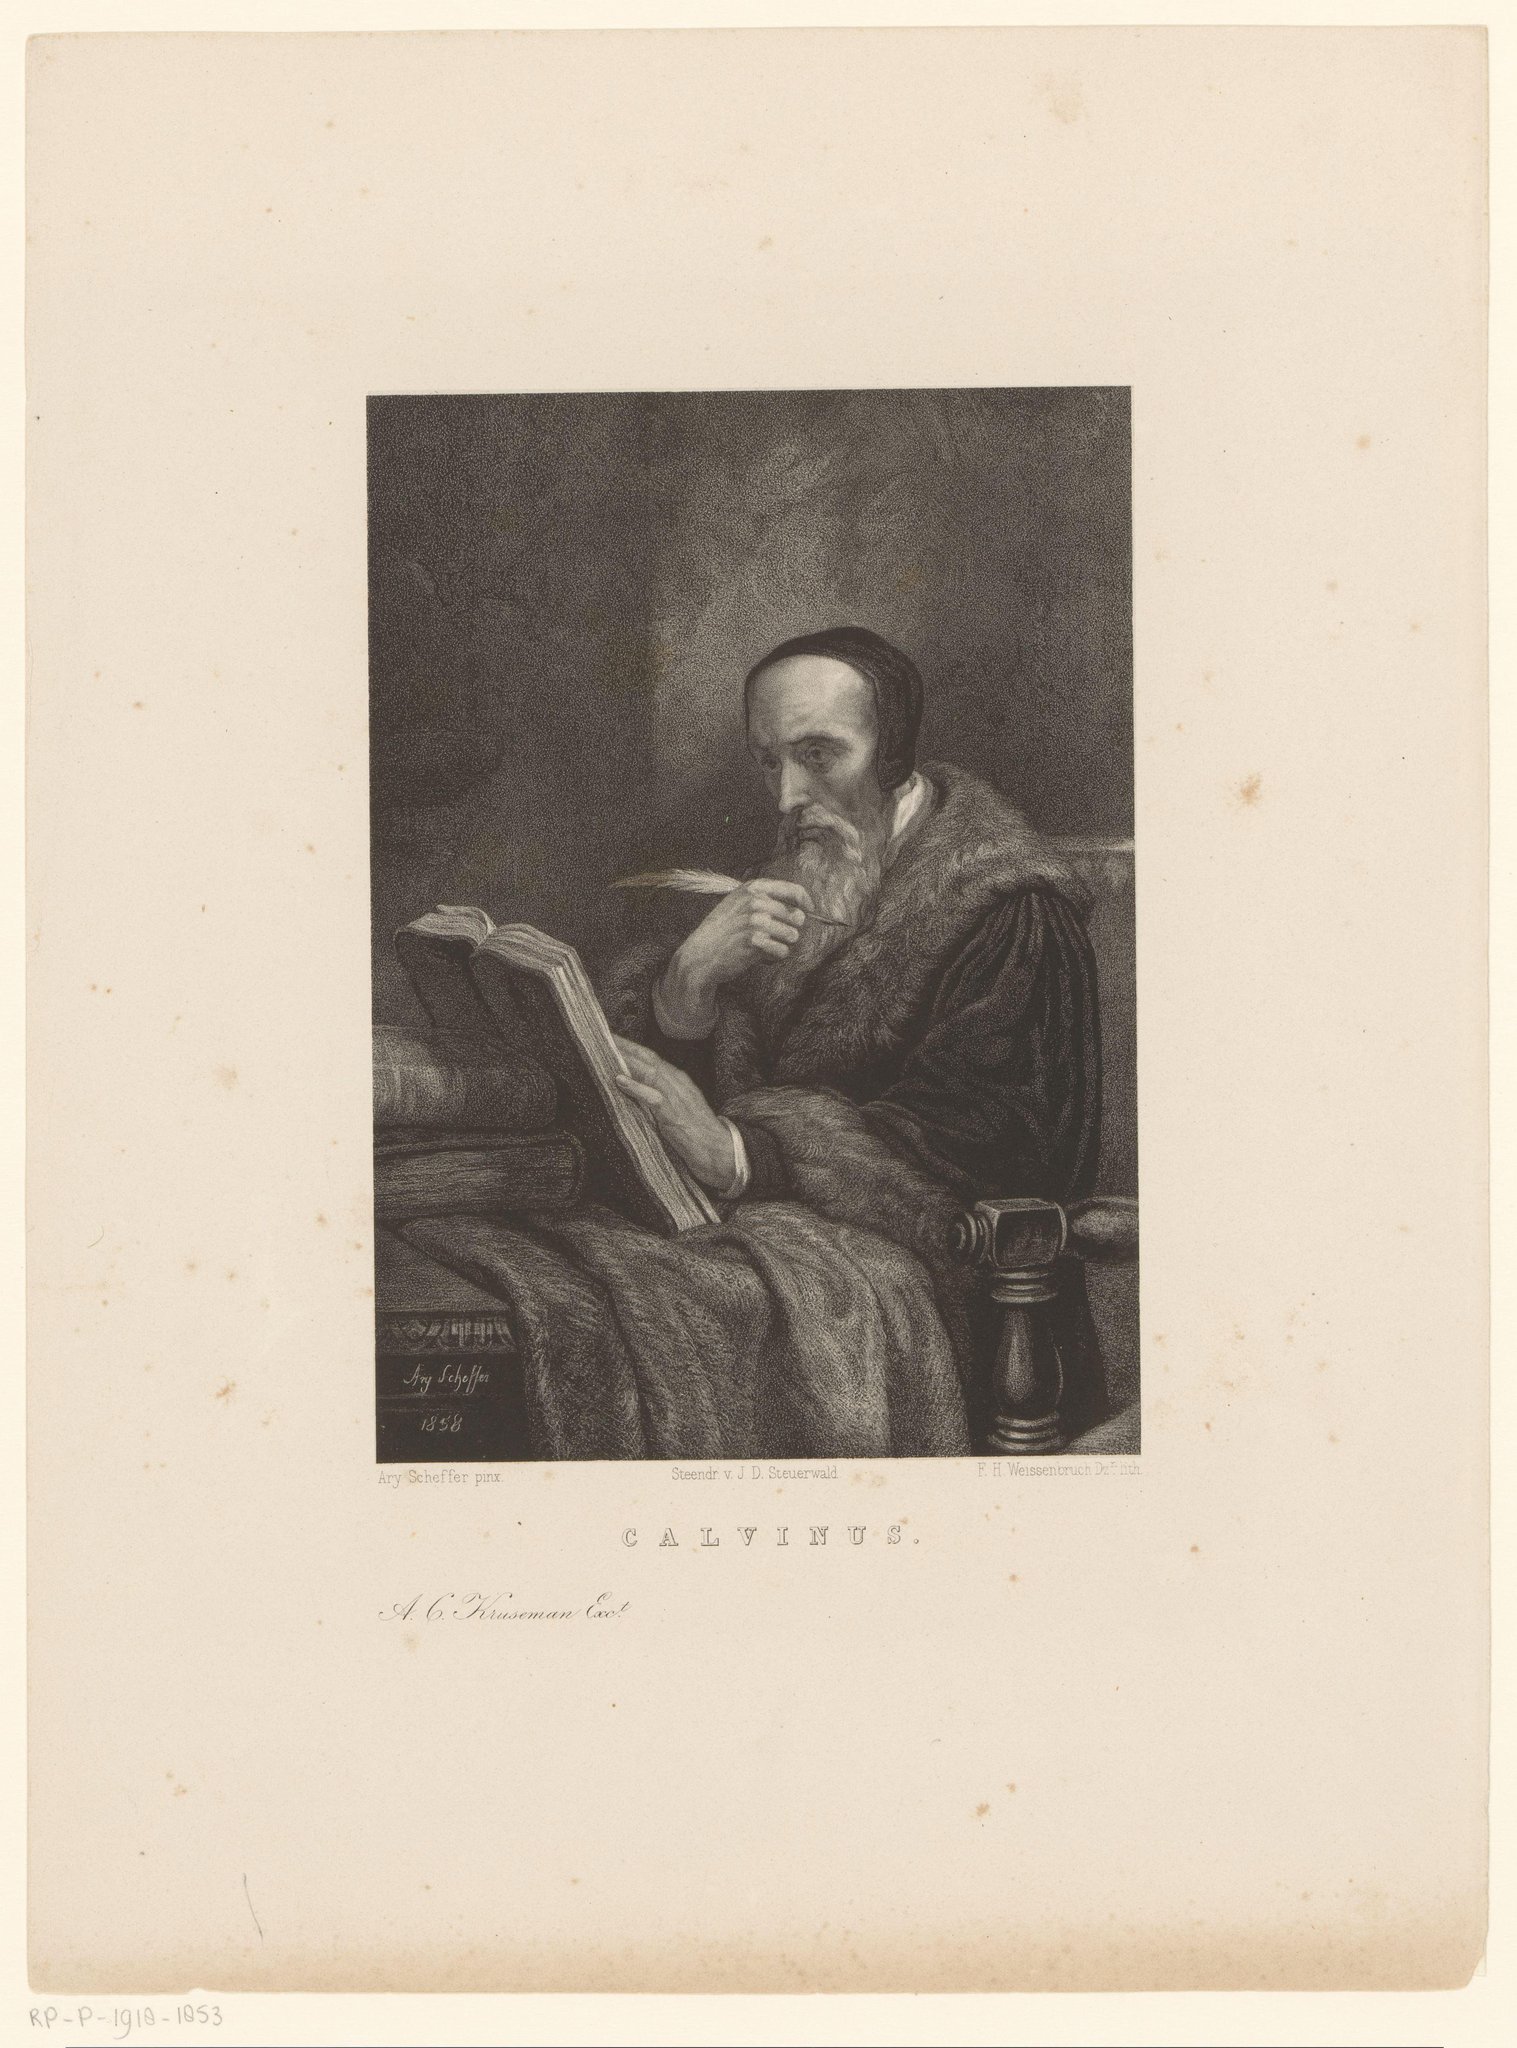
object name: print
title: Calvinus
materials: paper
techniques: lithograph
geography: the hague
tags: historical persons, writing and letters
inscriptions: collector's mark: Lugt 2233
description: Calvijn met een schrijfveer in zijn hand, zittend achter een tafel waarop boeken liggen.